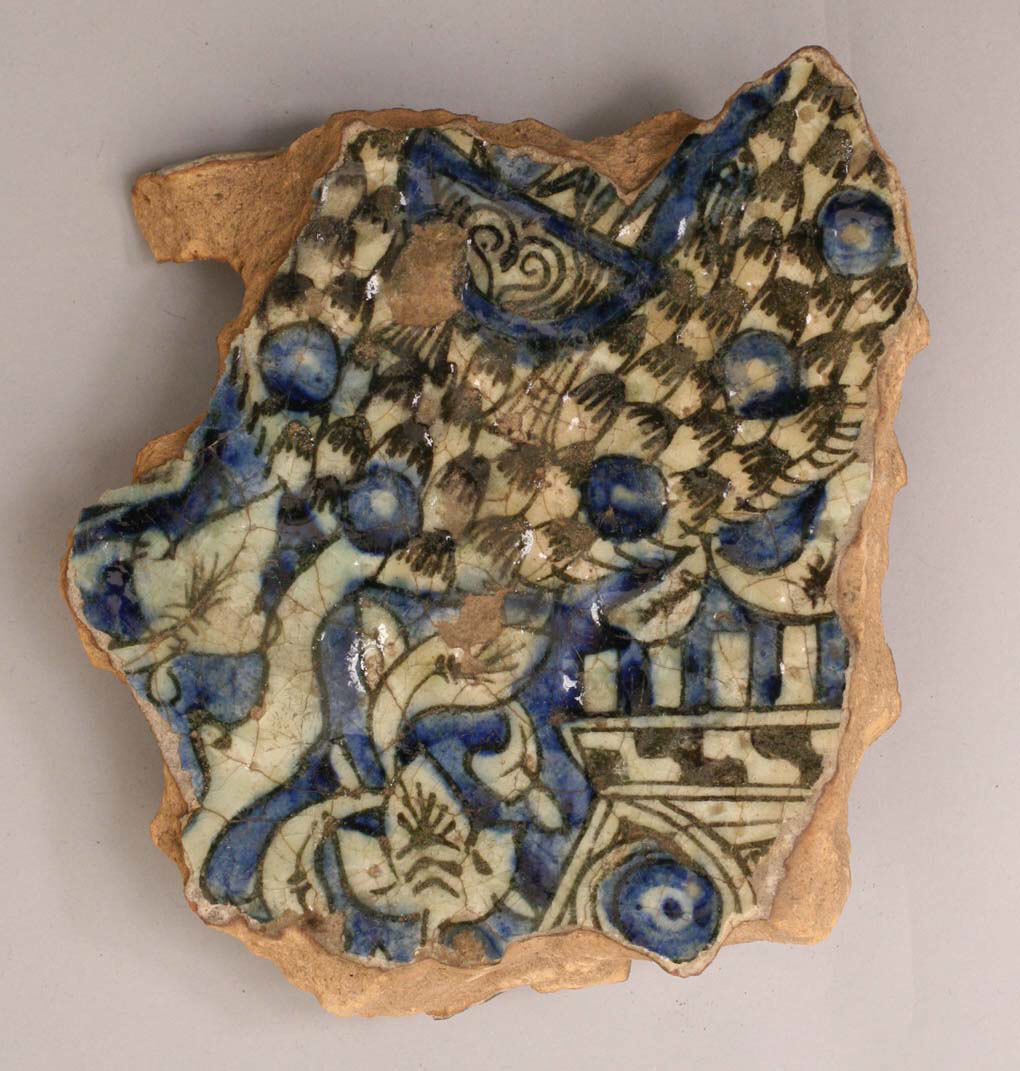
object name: fragment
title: Ceramic Fragment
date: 1301-1500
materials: glaze, stonepaste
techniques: underglaze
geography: egypt